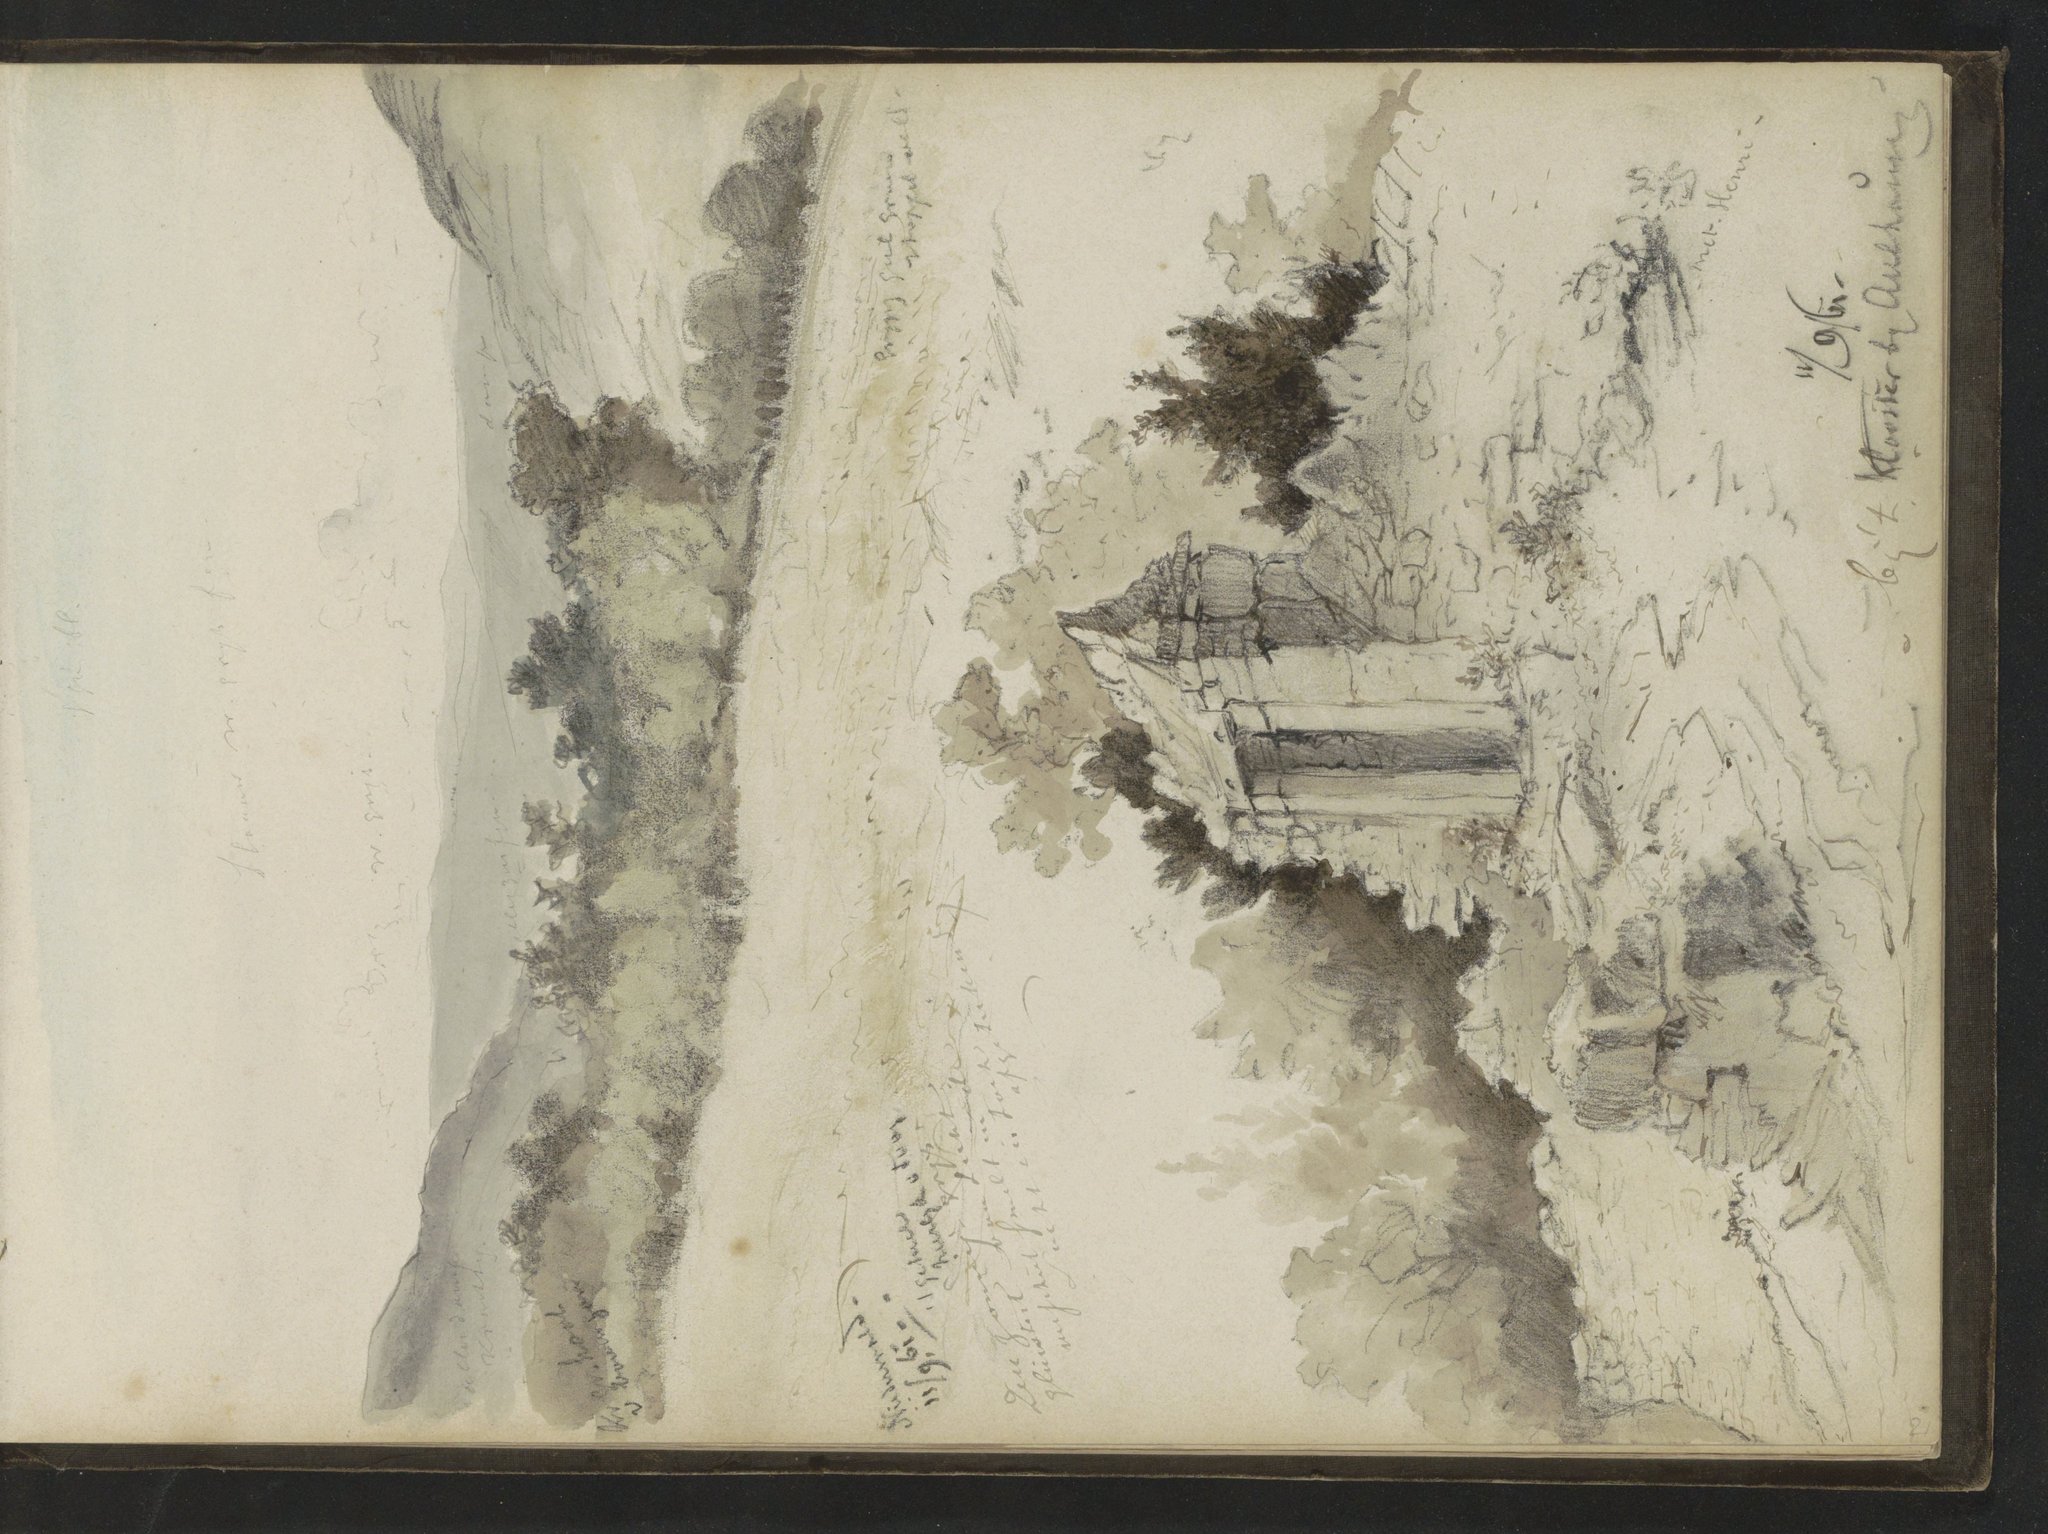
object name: sketchbook leaf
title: Gezicht op Niederwald en een ruïne van een klooster bij Aulhausen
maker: johannes tavenraat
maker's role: draughtsman, painter, print maker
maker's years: 1809-1881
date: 1809-1861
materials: ink, paper, pencil, watercolor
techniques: brush, pen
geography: rüdesheim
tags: ruin of a dwelling, house, castle, etc., mountains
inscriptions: date and inscription: ‘Niederwald/ 11/9 61-/ met Henri/ 11/9 61/ bij 't Klooster bij Aulhausen’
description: Blad 20 recto uit een schetsboek met 57 bladen.